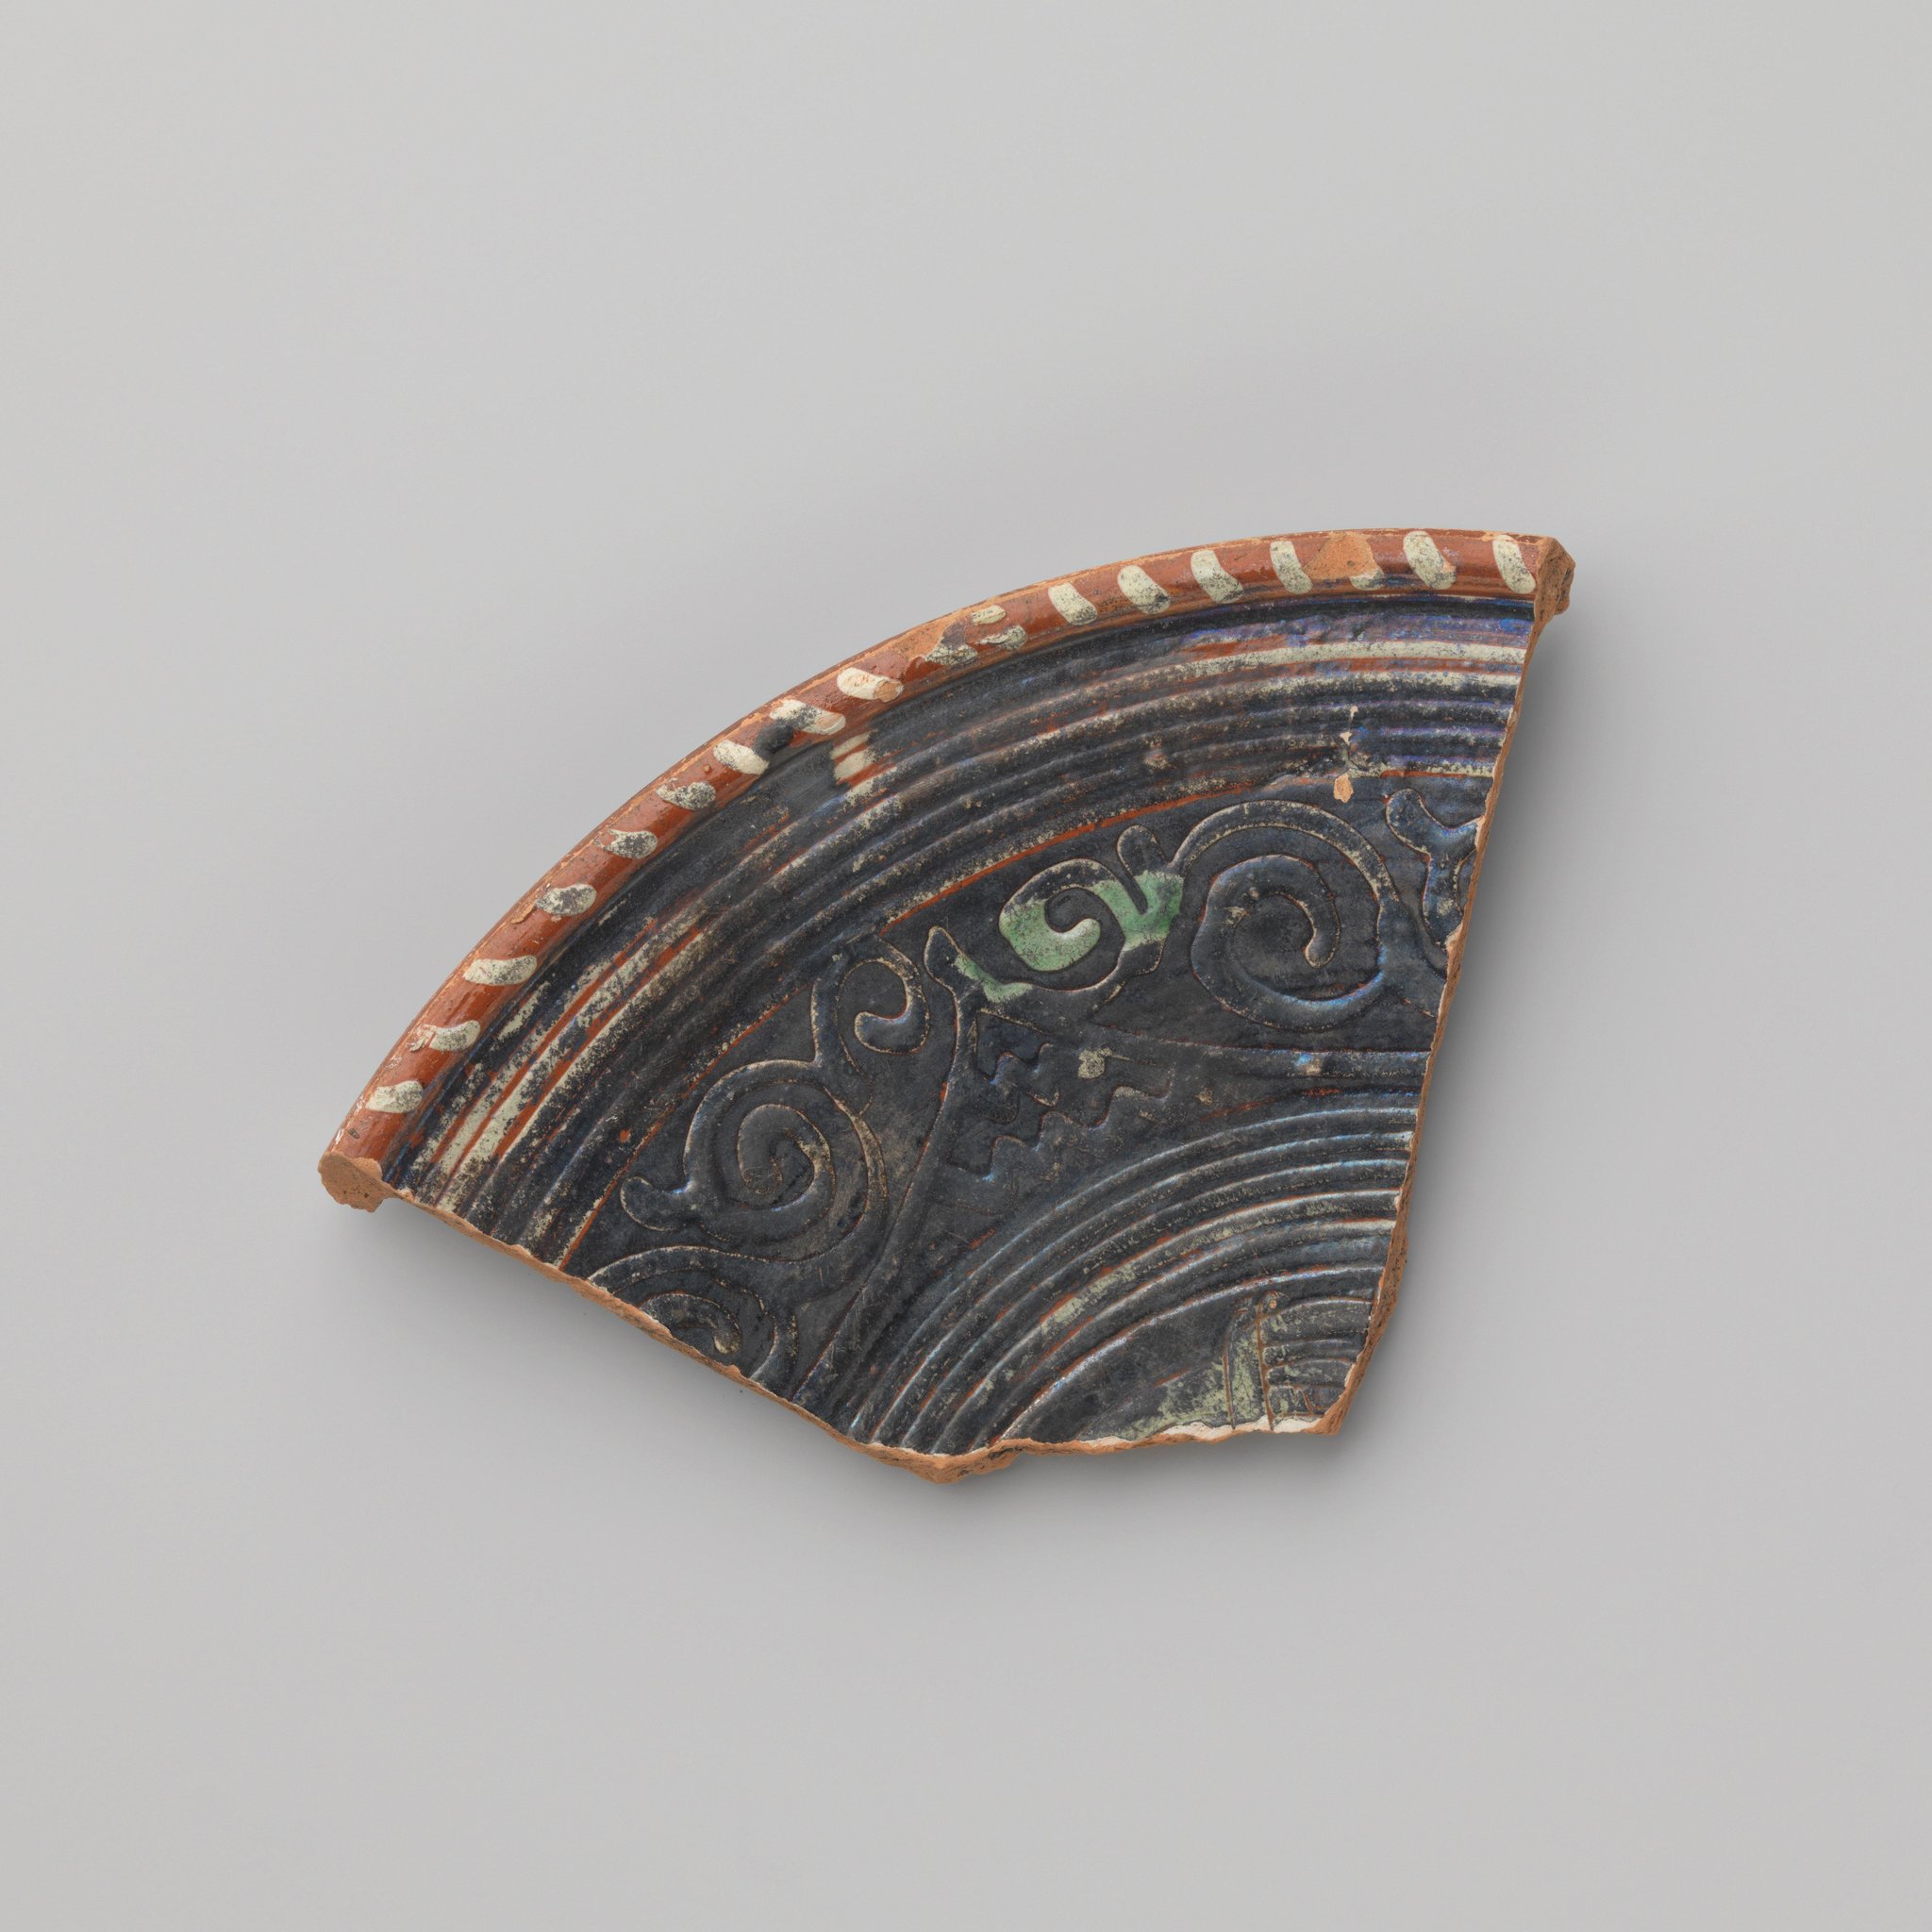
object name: fragment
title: Fragment van een schotel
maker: Anonymous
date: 1590-1620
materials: earthenware, glaze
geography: wanfried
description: Fragment van een schotel van loodglazuuraardewerk. Het fragment is gedecoreerd met ranken op de rand en streepjes langs de schotelrand.